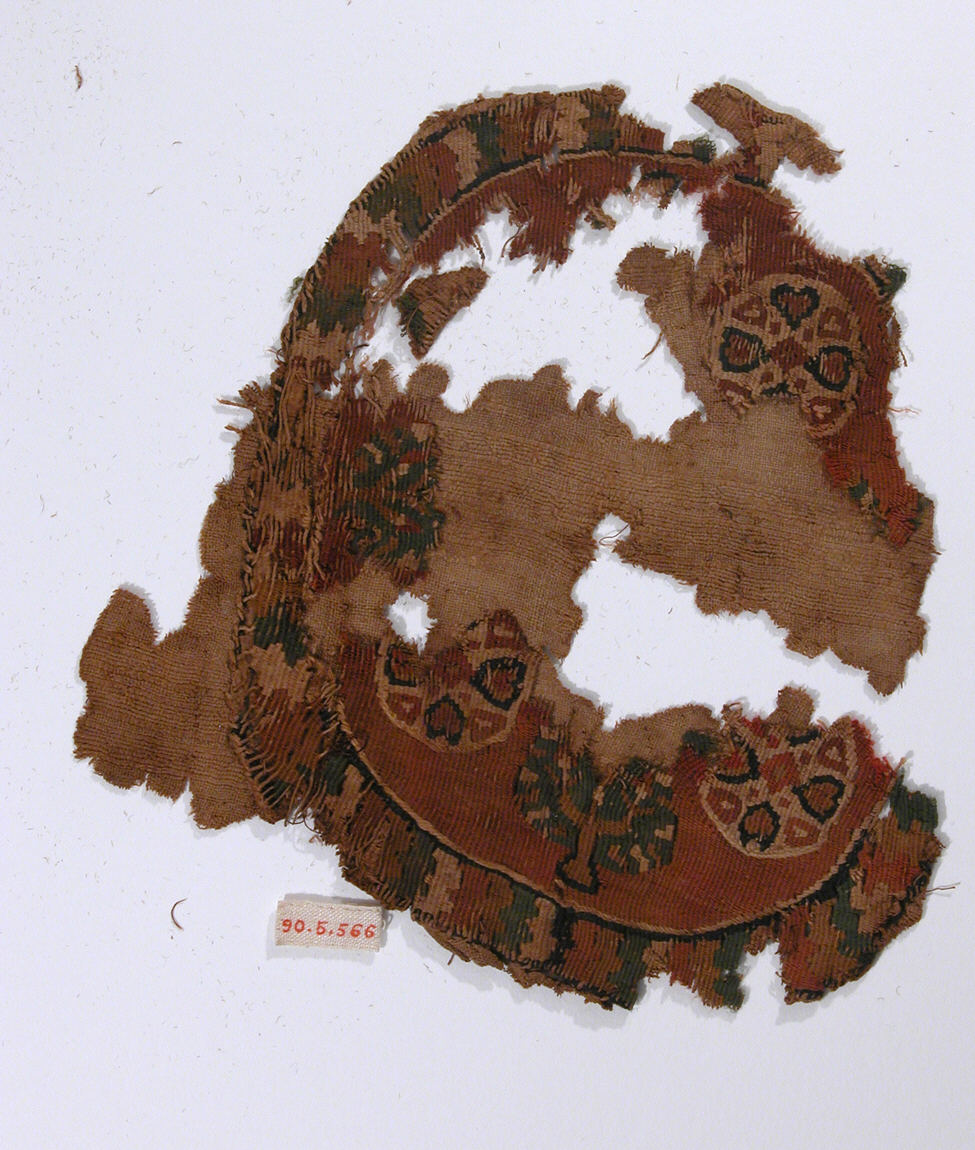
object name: textile fragment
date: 501-700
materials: linen, wool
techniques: weave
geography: egypt